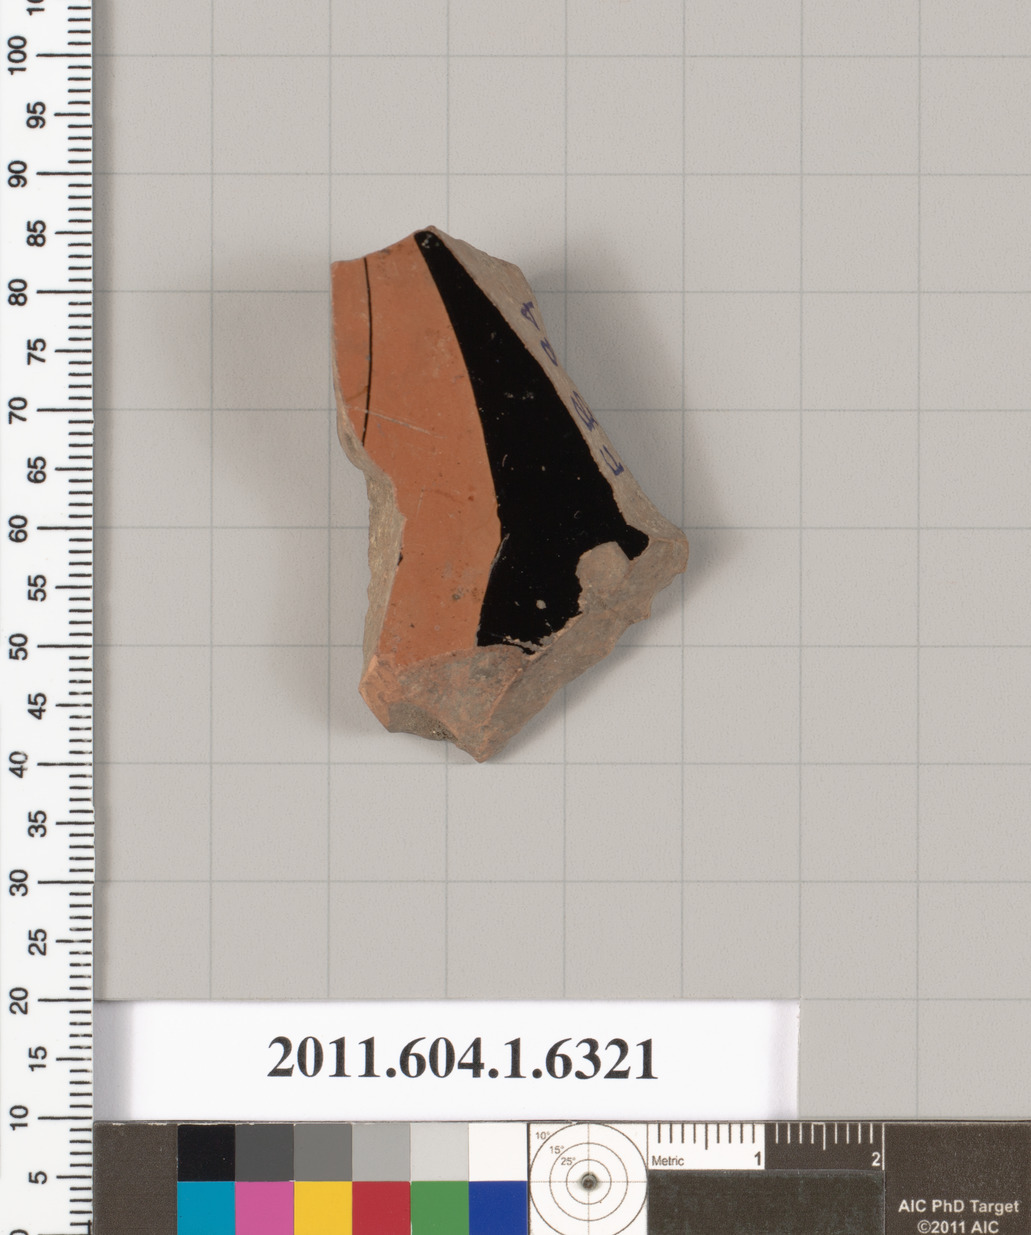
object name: kylix fragment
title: Terracotta fragment of a kylix (drinking cup)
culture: greek, attic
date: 500-480 BCE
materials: terracotta